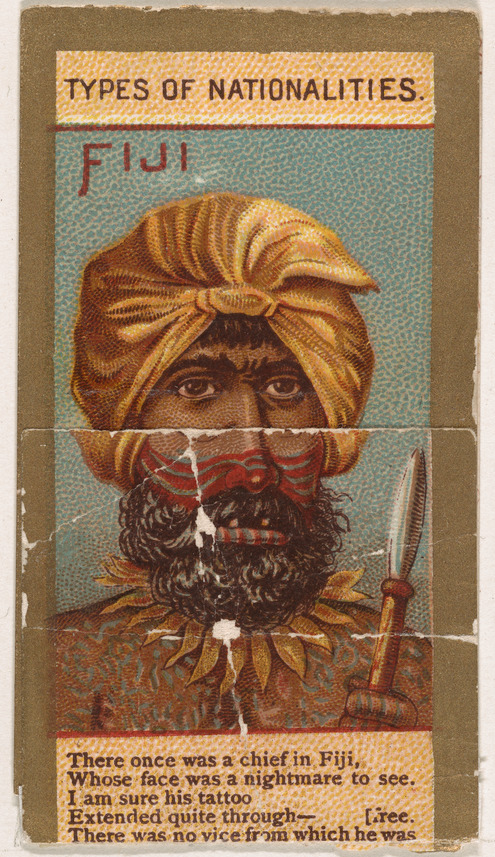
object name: print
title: Fiji, from Types of Nationalities (N240) issued by Kinney Bros.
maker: kinney brothers tobacco company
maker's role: publisher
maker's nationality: american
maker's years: 1869-2011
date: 1890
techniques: color lithograph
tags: men